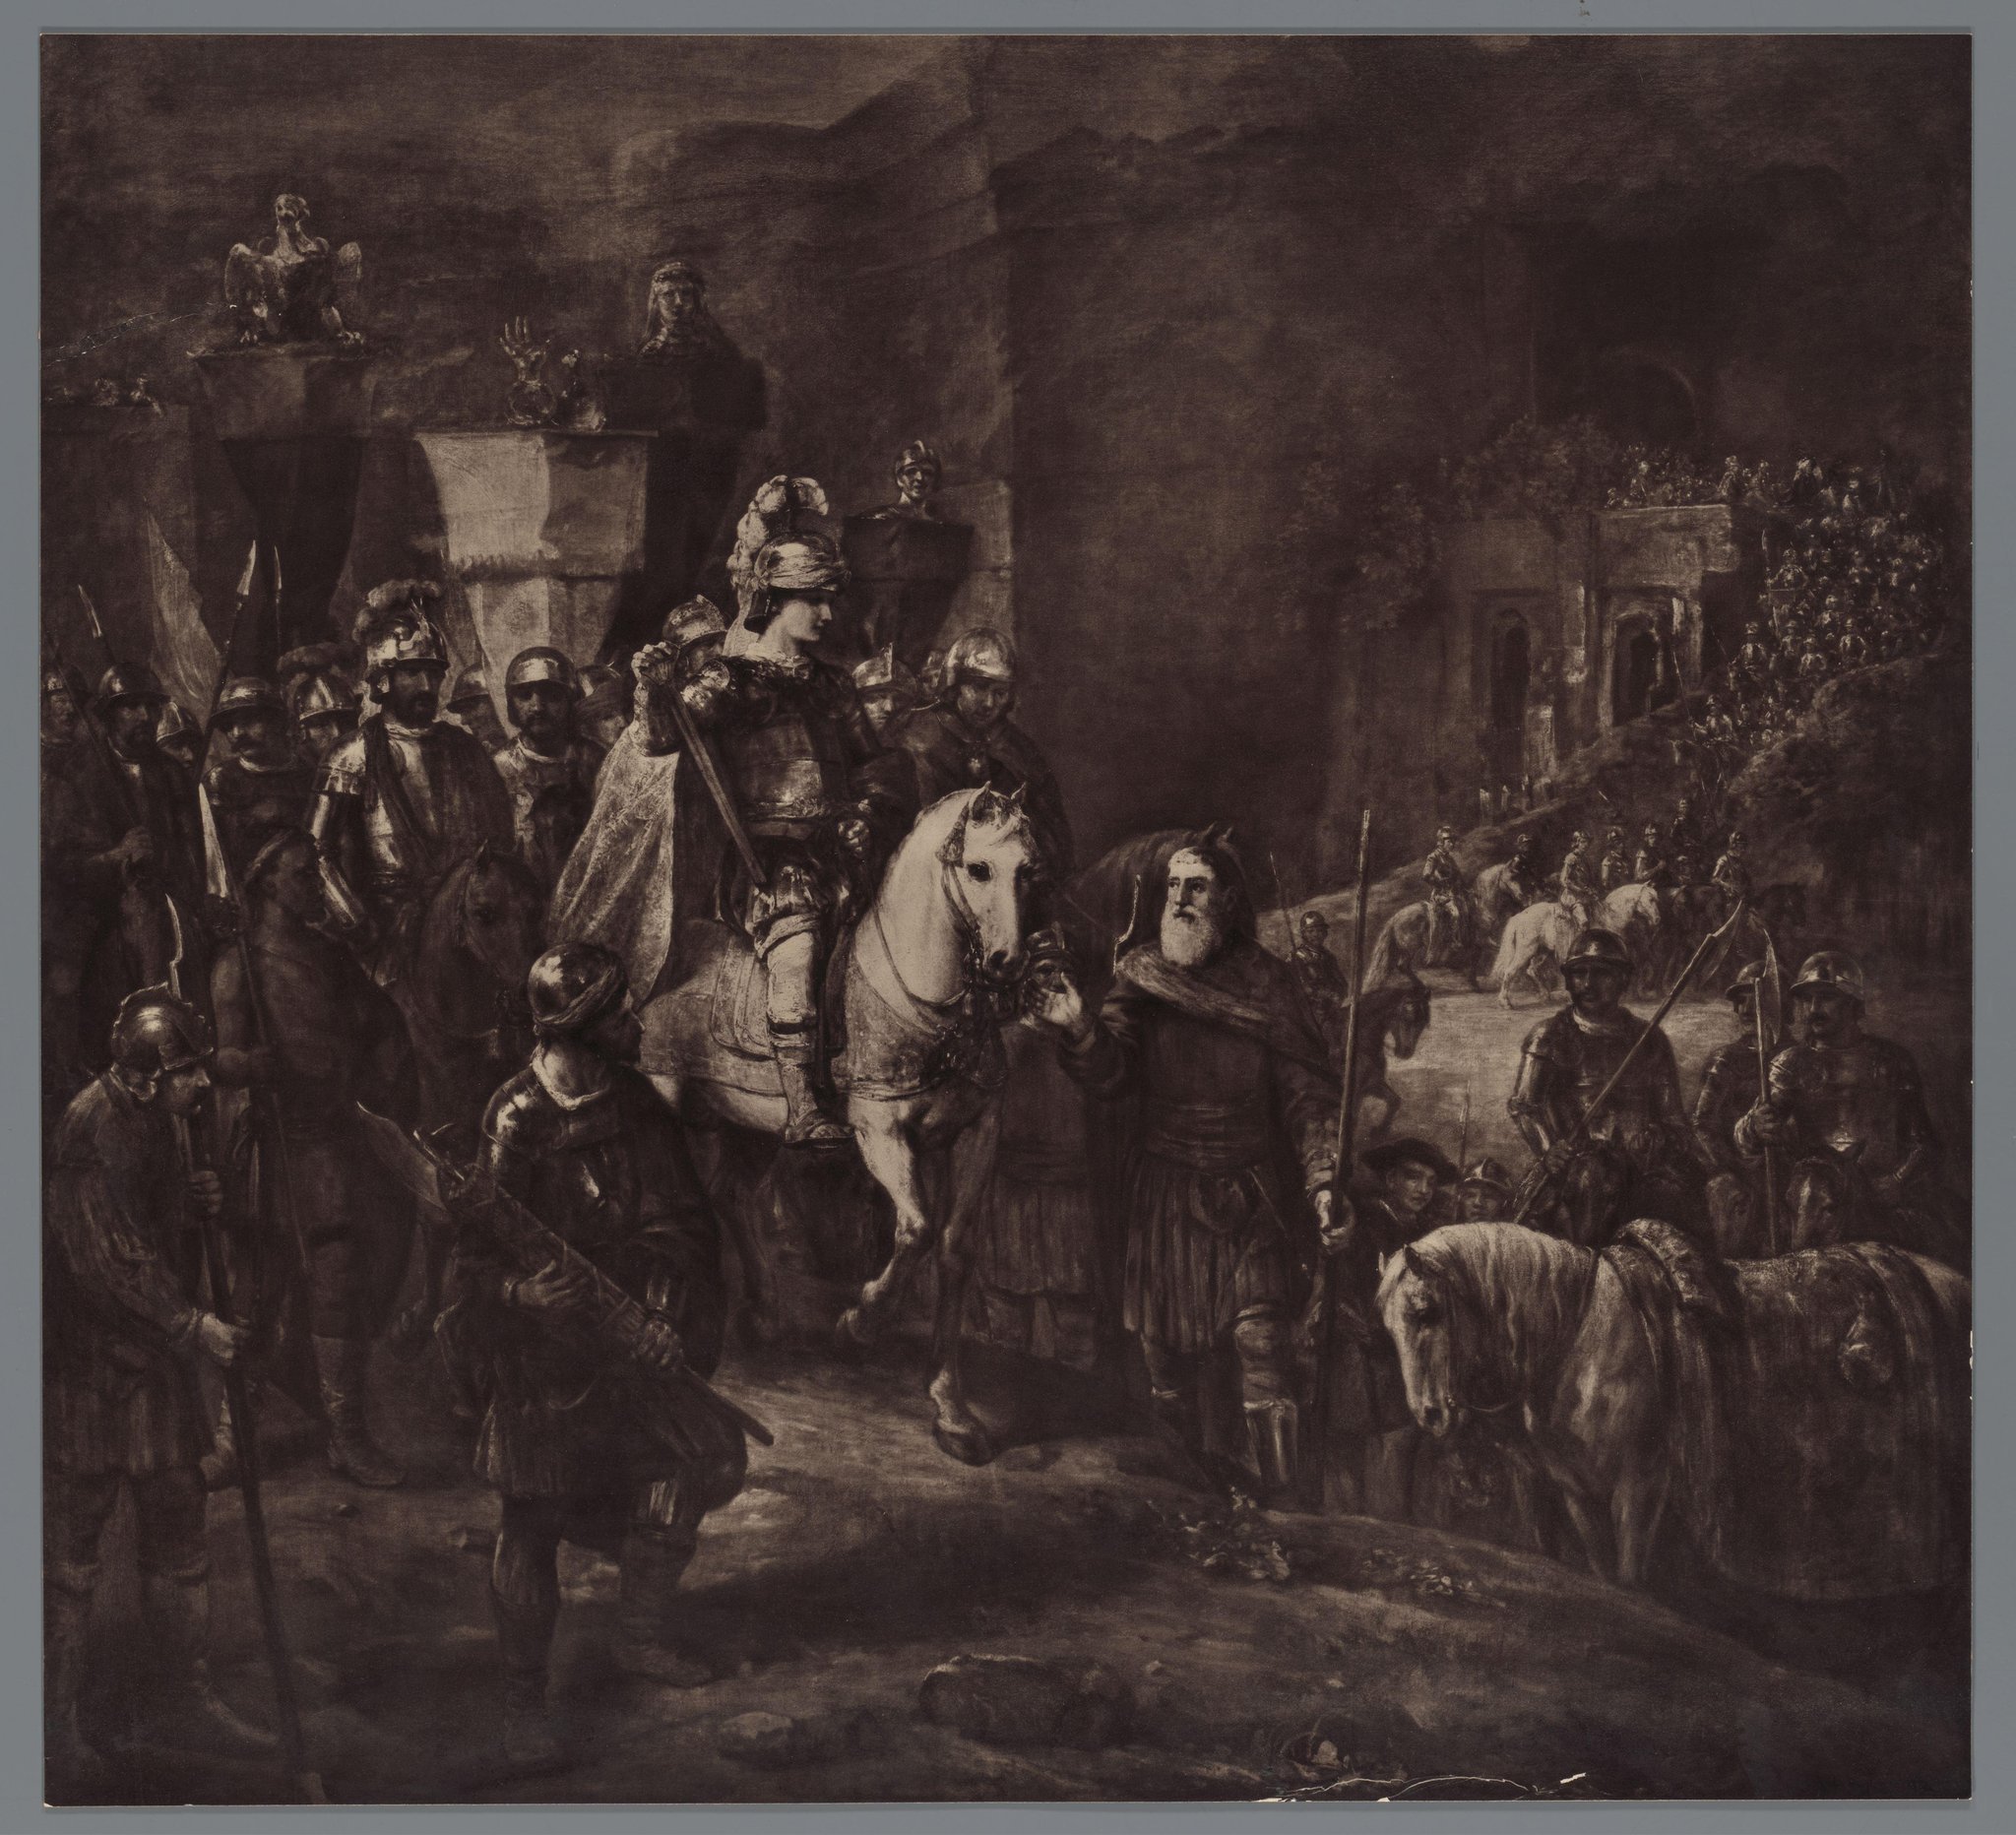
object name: photograph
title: Fotoreproductie van een schilderij van Rembrandt, 'Quintus Fabius Maximus' (Bredius 477)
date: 1880-1900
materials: cardboard, paper, photographic support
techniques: carbon print